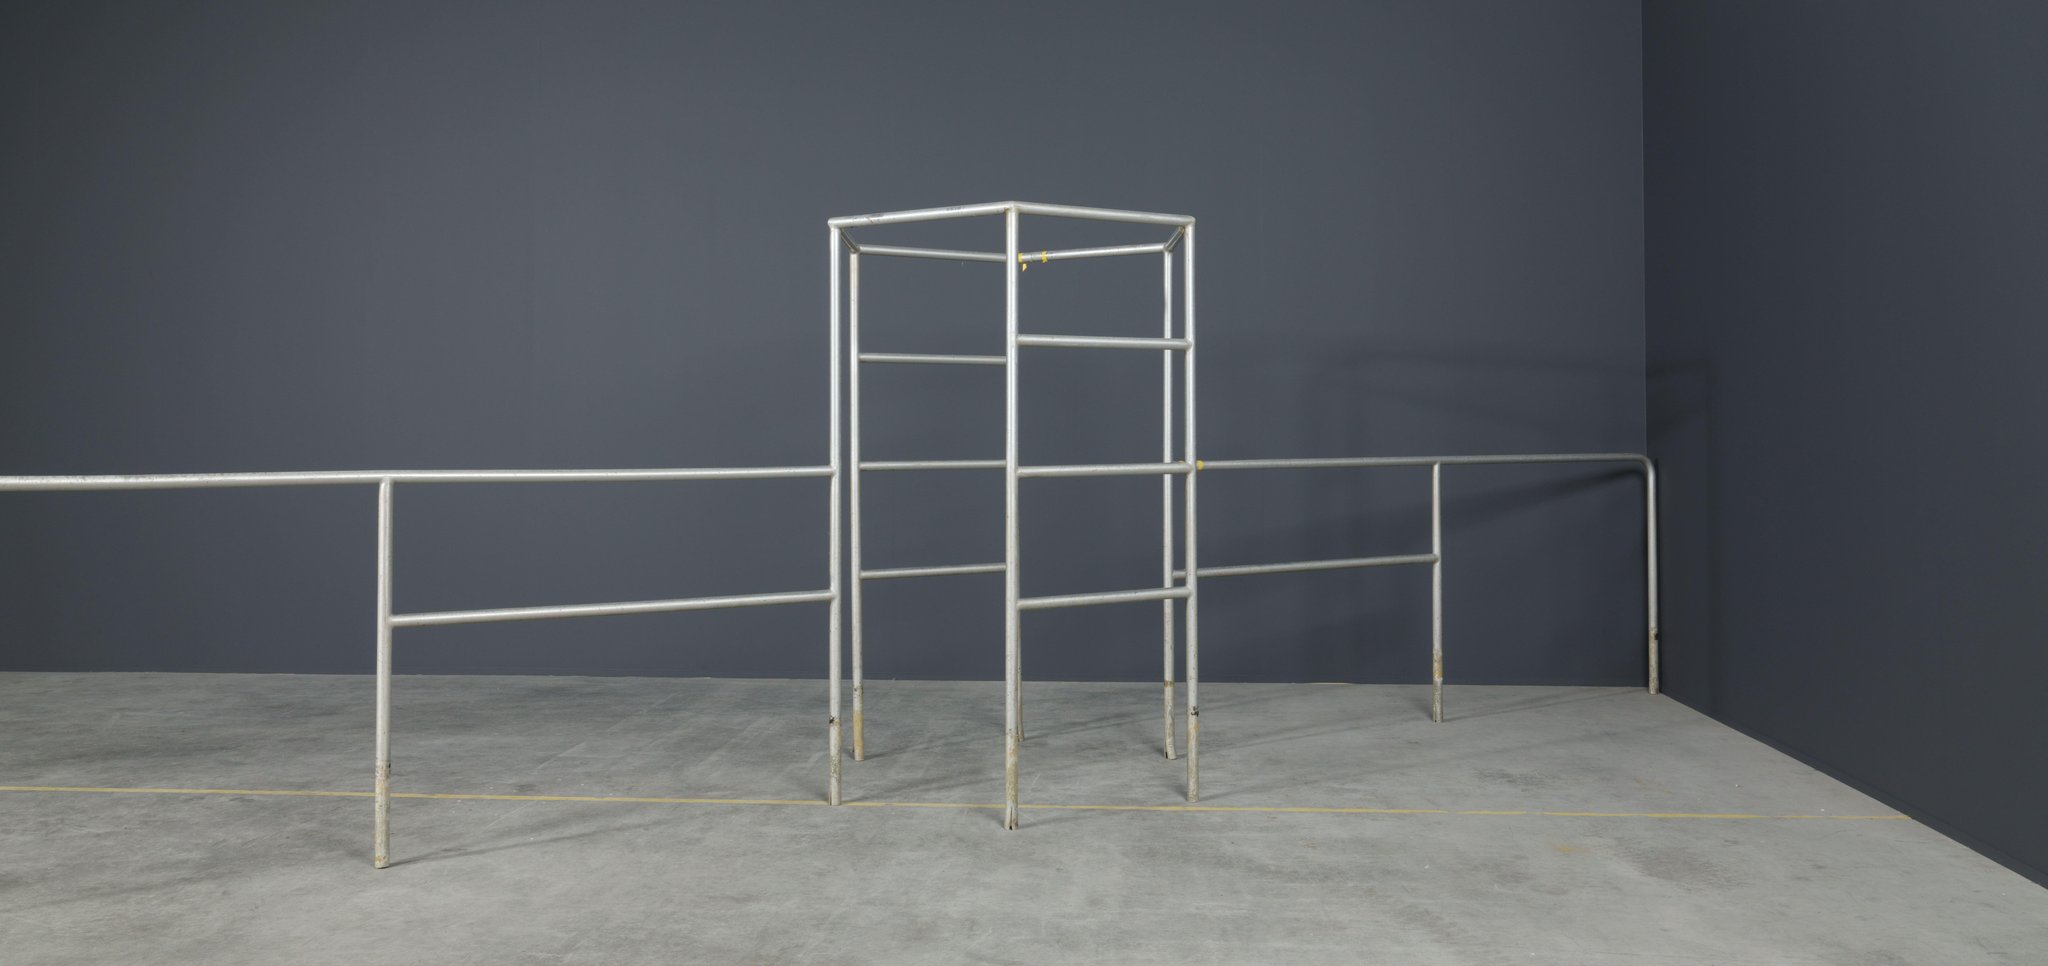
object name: speeltoestel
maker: aldo van eyck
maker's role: architect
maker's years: 1918-1999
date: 1962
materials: aluminum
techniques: welding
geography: netherlands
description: Aluminium buis, onderdeel van een speeltoestel.